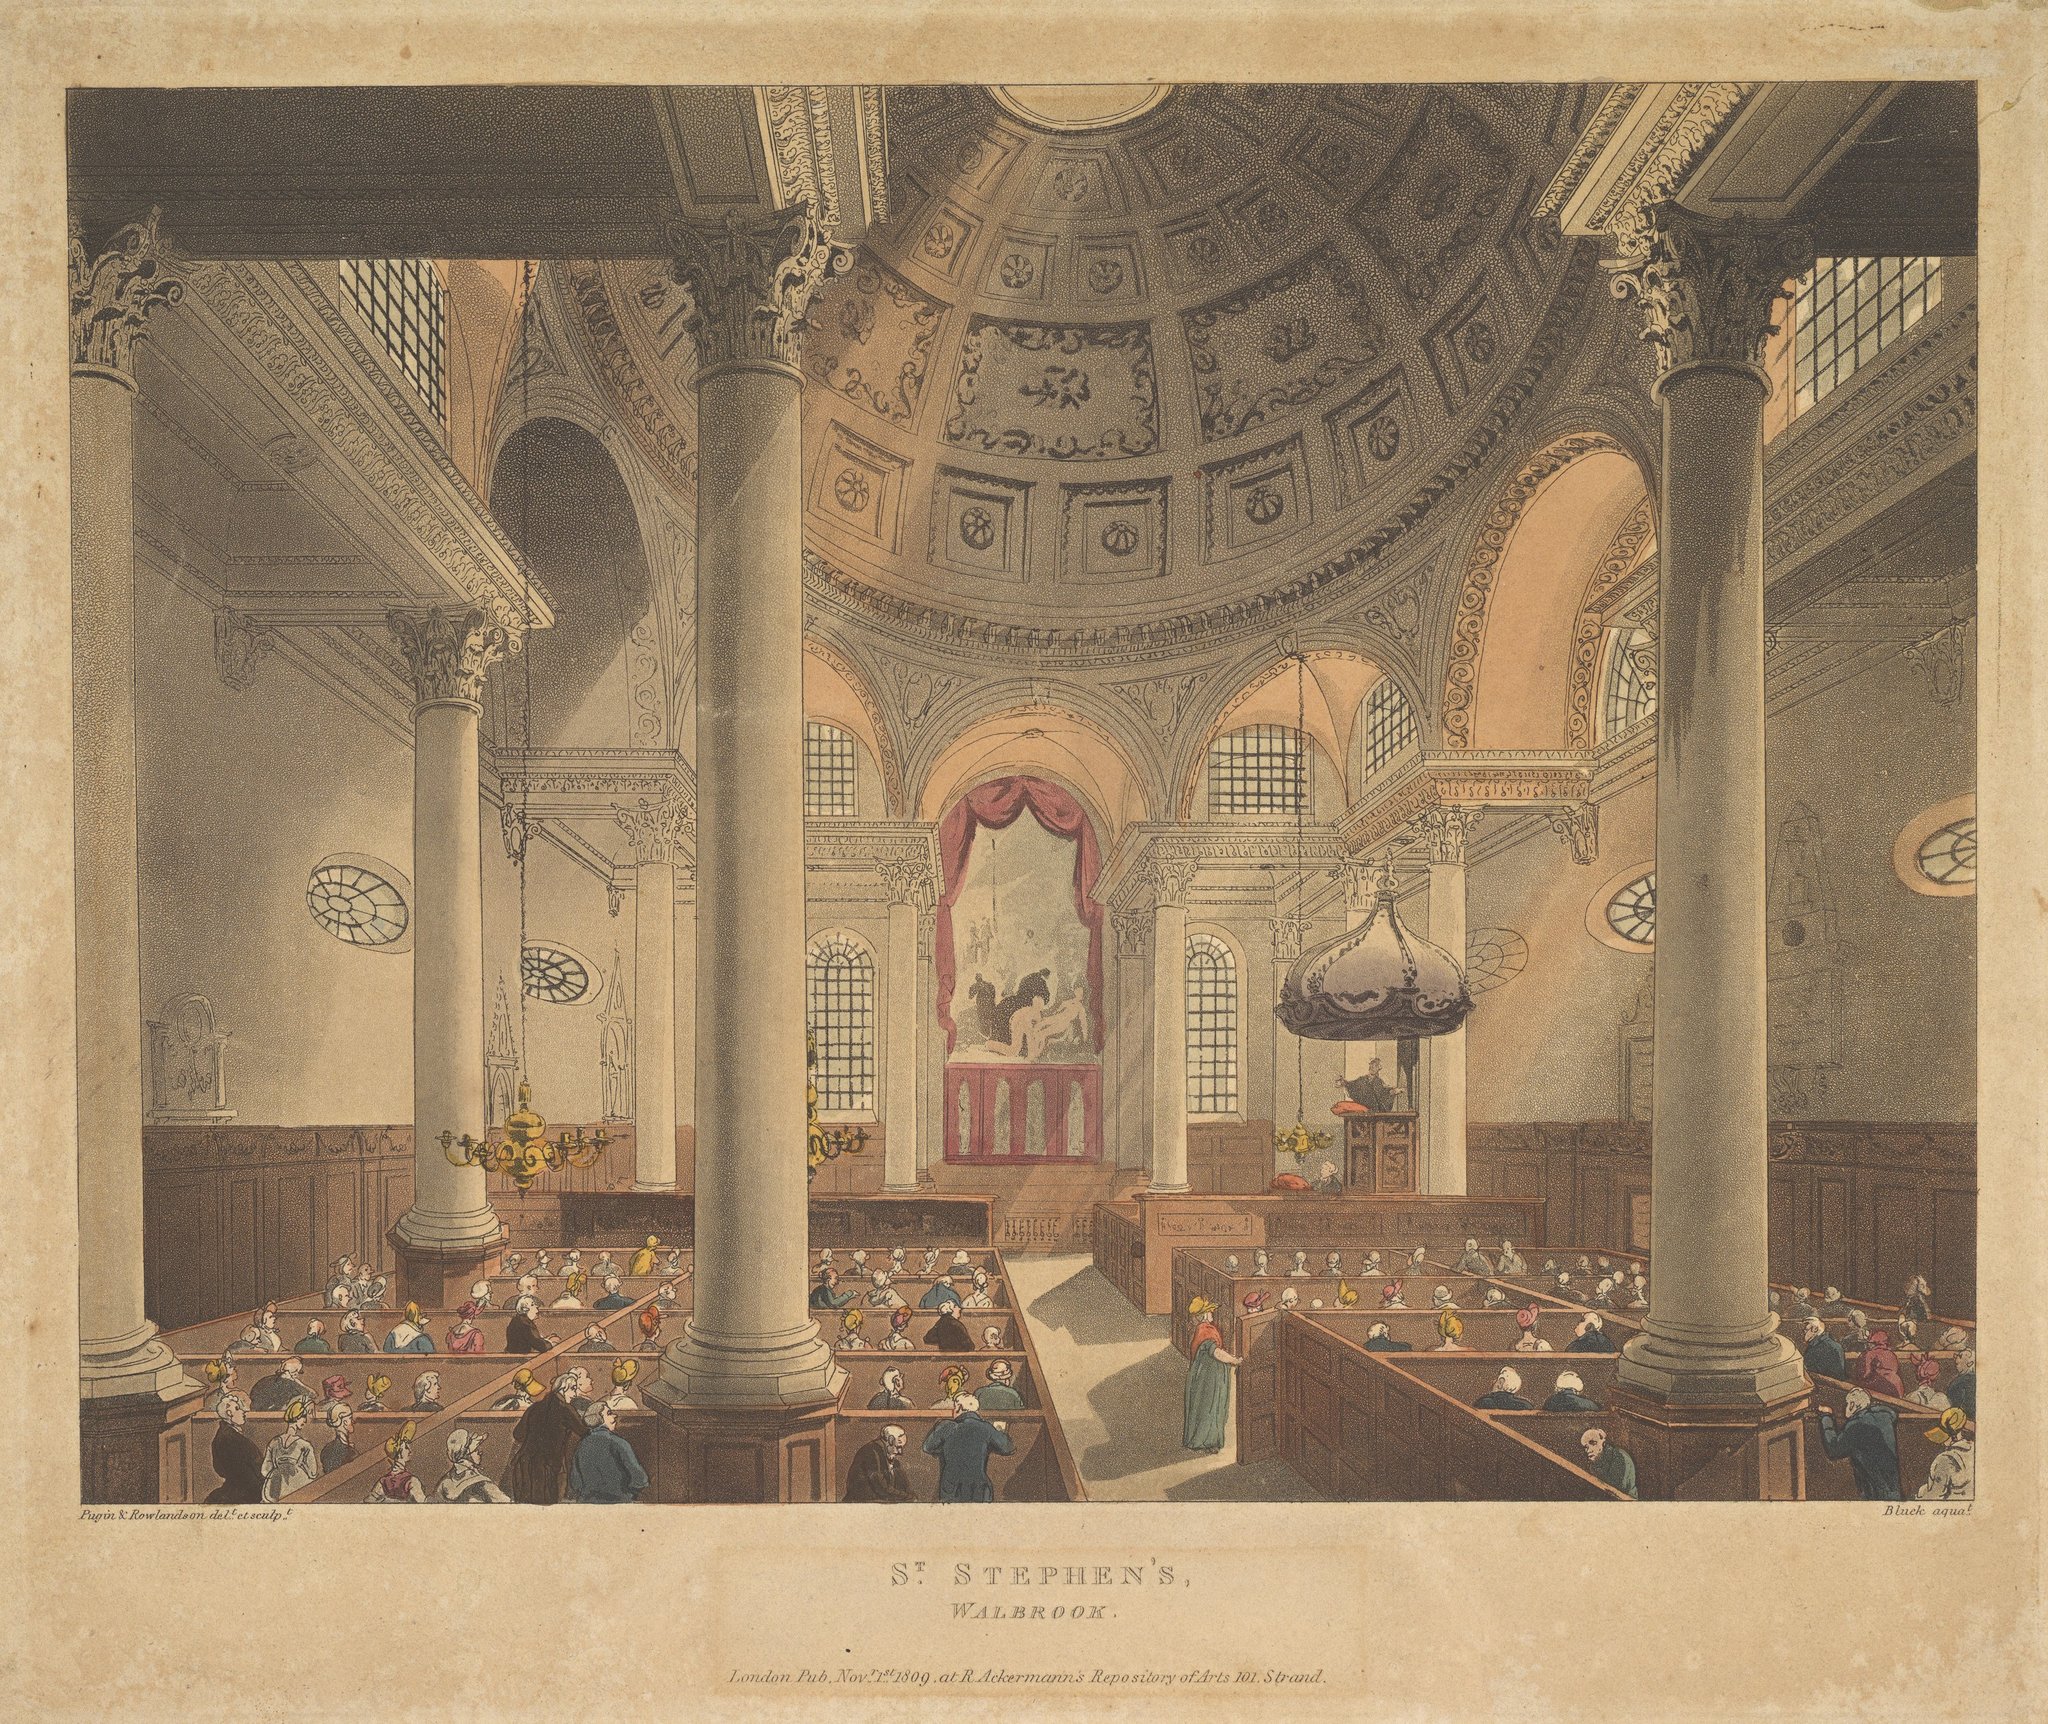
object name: print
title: St. Stephen's Walbrook, plate 90 from "Microcosm of London"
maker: thomas rowlandson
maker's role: artist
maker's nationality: british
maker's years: 1757-1827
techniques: aquatint, etching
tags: interiors,churches